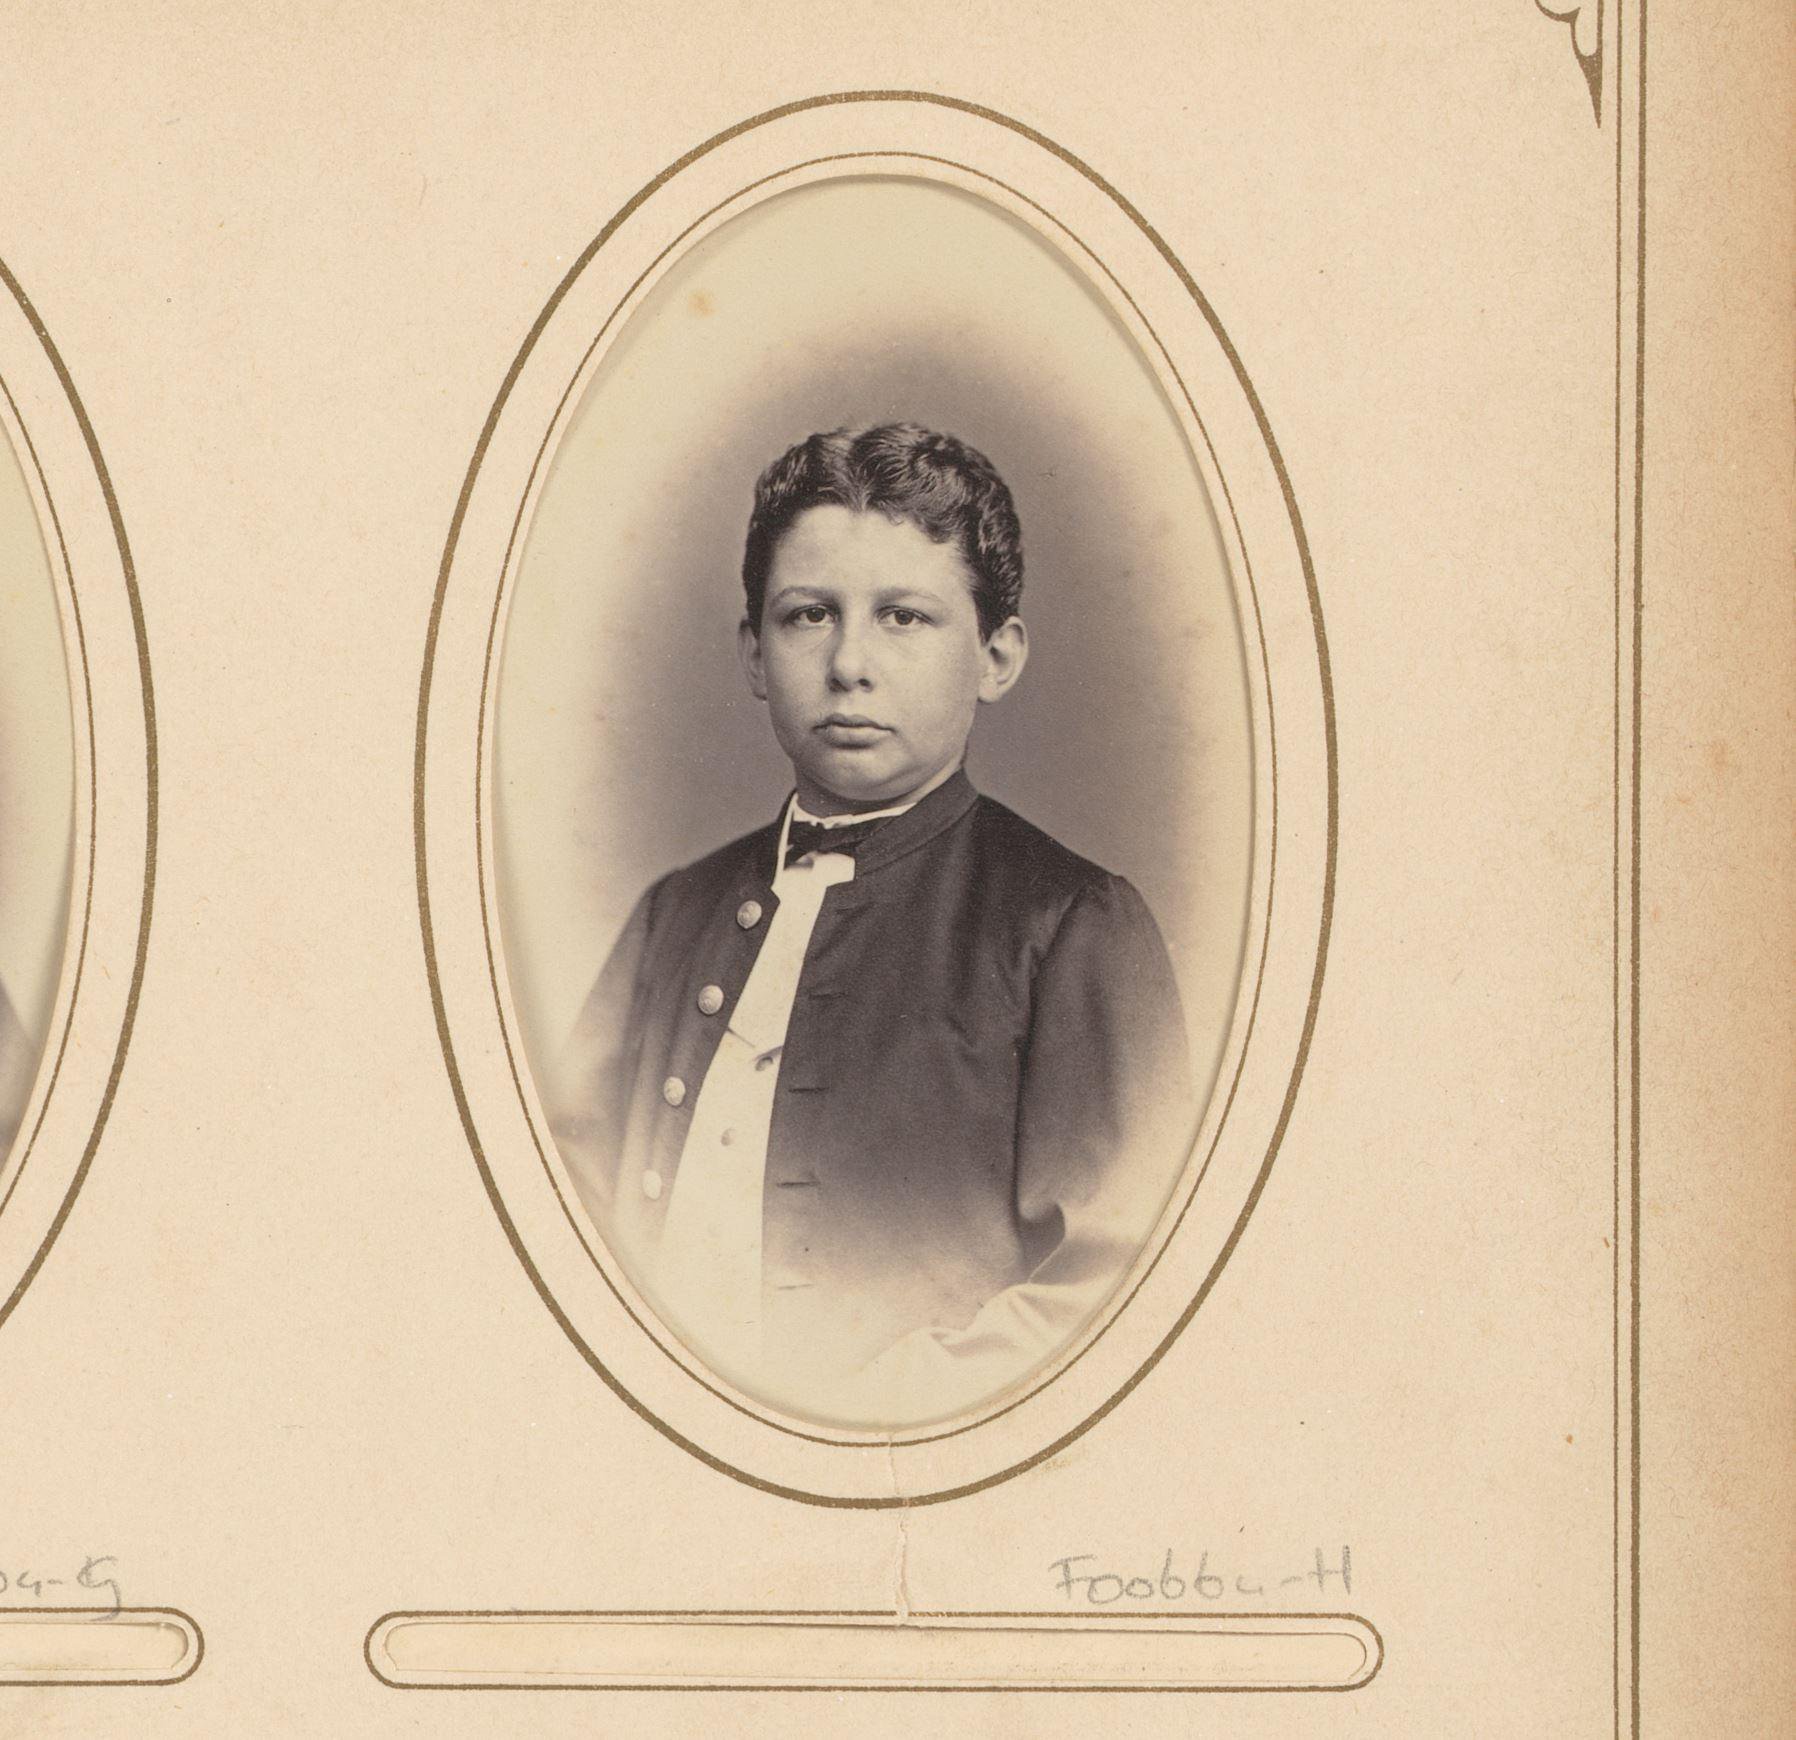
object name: carte de visite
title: Portret van een jongeman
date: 1860-1880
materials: cardboard, photographic support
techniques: albumen print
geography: java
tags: boy (child between toddler and youth)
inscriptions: inscription: ‘Woodbury & Page/ Photographers/ Java’